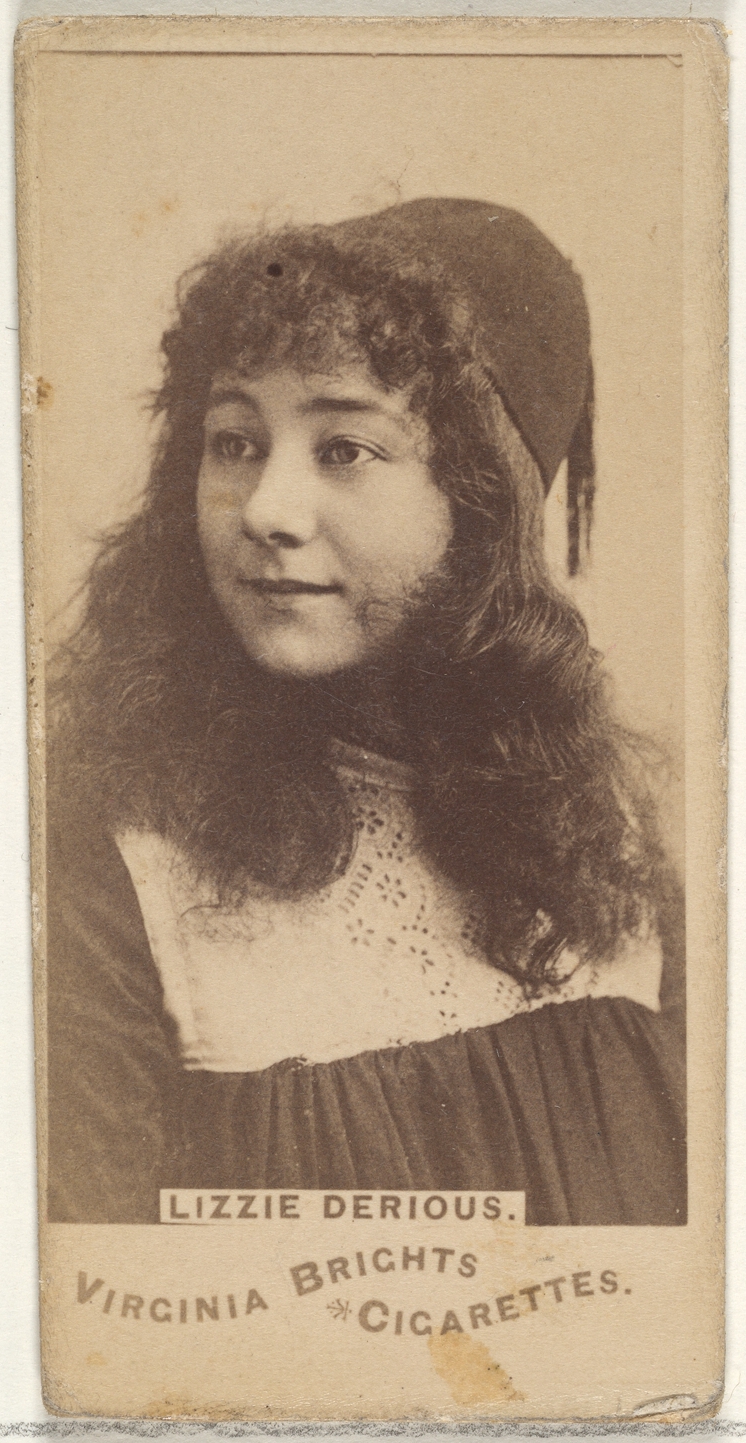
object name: photograph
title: Lizzie Derious, from the Actors and Actresses series (N45, Type 1) for Virginia Brights Cigarettes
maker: allen & ginter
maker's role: publisher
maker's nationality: american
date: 1888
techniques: albumen silver print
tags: portraits,women,actresses